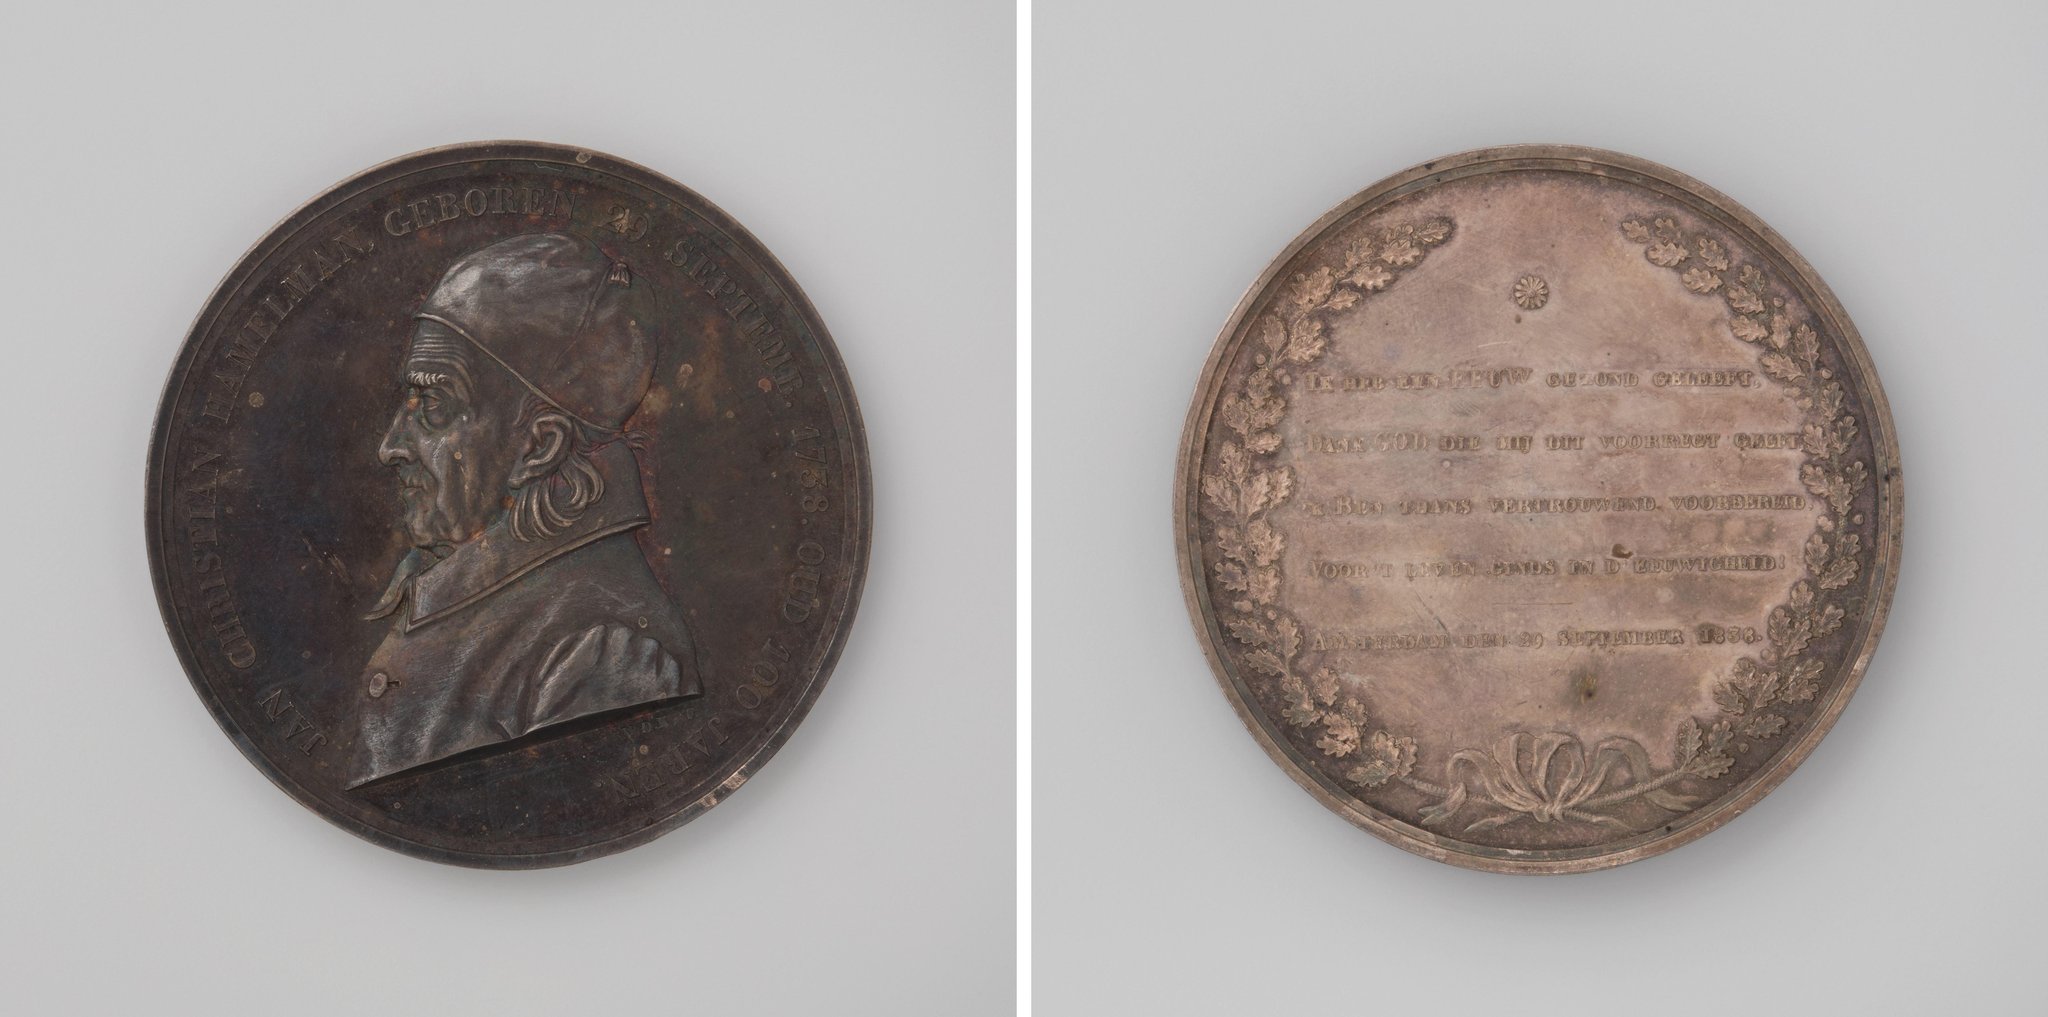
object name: family medal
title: Honderdste verjaardag van Jan Christiaan Hamelman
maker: david van der kellen (1804-1879)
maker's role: die cutter, draughtsman, print maker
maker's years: 1804-1879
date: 1838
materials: silver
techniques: striking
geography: utrecht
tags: amsterdam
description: Zilveren penning. Voorzijde: borststuk man met muts binnen omschrift. Keerzijde: opschrift onder sterbinnen eikekrans